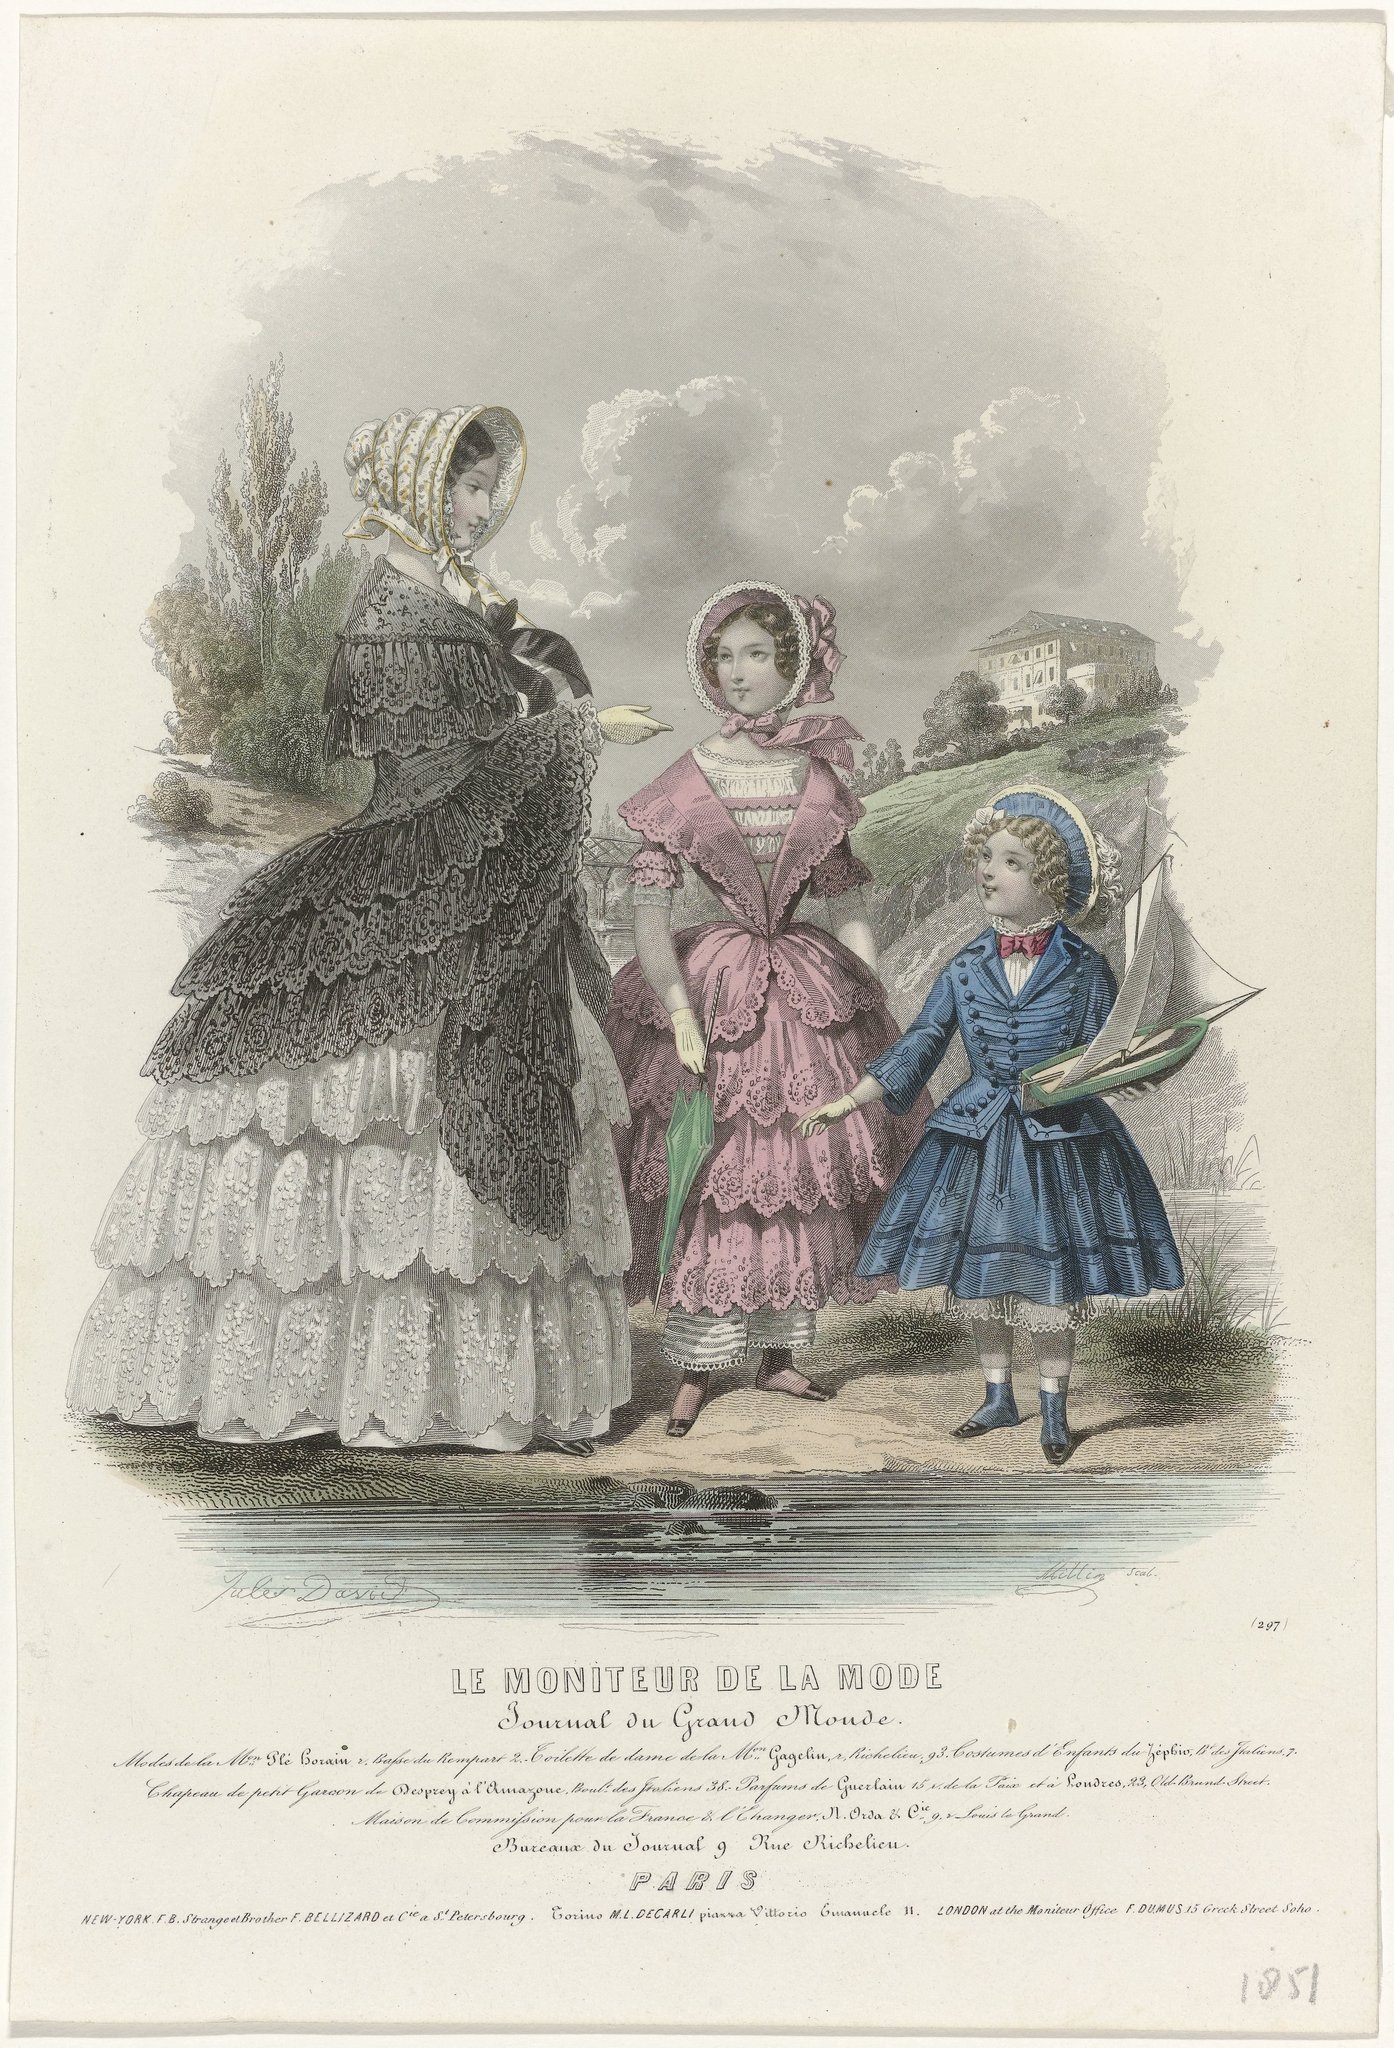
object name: fashion print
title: Le Moniteur de la Mode, juni 1851, No. 297 : Modes de la M"on Plé Horain (...)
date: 1851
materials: paper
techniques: hand coloring, engraving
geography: london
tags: clothes, costume (+ girls' clothes), parasol, sunshade (+ girls' clothes), head-gear (+ boys' clothes), clothes, costume (+ boys' clothes), coat (+ women's clothes), head-gear (+ women's clothes), fashion plates, skirt (+ women's clothes), gloves, mittens, etc. (+ women's clothes), (playing with) boats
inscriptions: address: ‘Bureaux du Journal 9 Rue Richelieu. / Paris. / New-York. E.B. Strange et Brother. F. Bellizard et C.ie à S.t Pétersbourg. Torino M.L. Decarli piazza Vittorio Emanuele 11. London at the Moniteur Office. F. Dumus 15 Greek Street Soho.’, title: ‘Le Moniteur de la Mode. / Journal du Grand Monde..’, caption: ‘Modes de la M"on Plé Horain r. Basse du Rempart 2.Toilette de dame de la M"on Gagelin, r. Richelieu, 93. Costumes d'Enfants du Zéphir. Bt des Italiens, 7. Chapeau de petit Garçon de Desprey à l'Amazone. Boult des Italiens 38. parfums de Guerlain 15 r. de la Paix et à Londres, 23, Old-Brund-Street. Maison de Commission pour la France & l'Etranger, N. orda & Cïe 9, r Louis le Grand.’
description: Een vrouw en twee kinderen, van wie één met speelgoedboot in de hand, bij de waterkant. Op de achtergrond een landgoed. Volgens het onderschrift: 'modes' van Plé Horain. 'Toilette' van de vrouw van Maison Gagelin. Kinderkleding van Zéphir. Hieronder enkele regels reclametekst voor verschillende producten. Prent uit het modetijdschrift Le Moniteur de la mode (1843-1913).